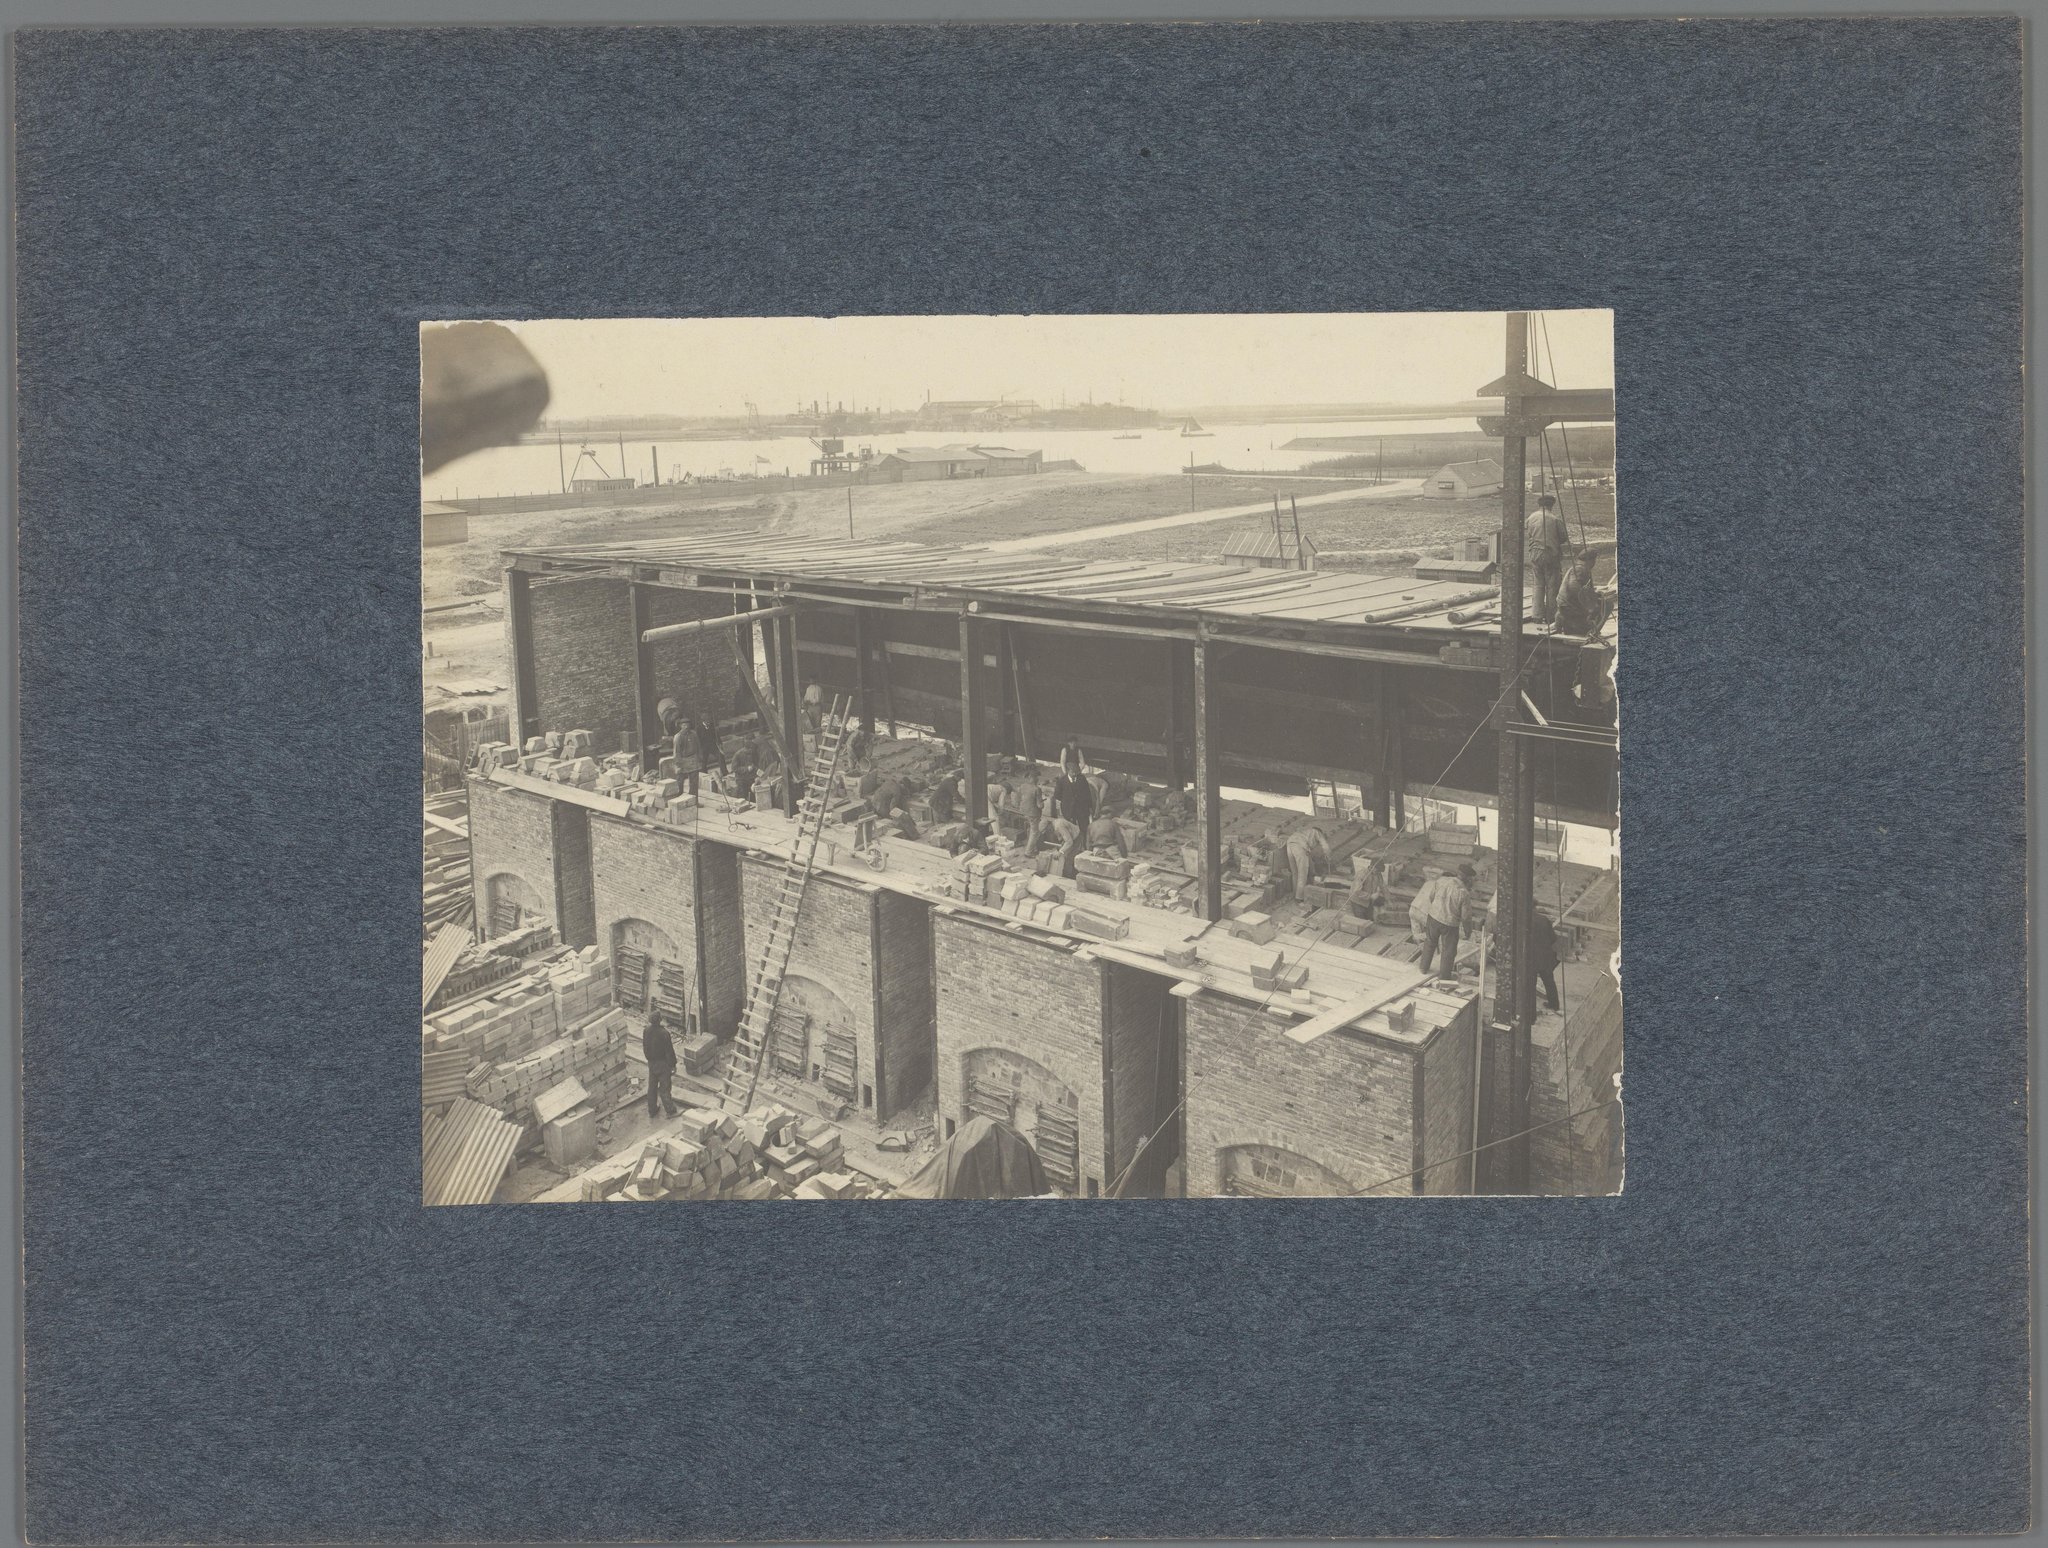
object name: photograph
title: Bouw van een opslagplaats in de Keilehaven, op de achtergrond de Maas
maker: willem sr. bleuzé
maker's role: fotograaf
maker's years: 1873-1948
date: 1912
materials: paper, cardboard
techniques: gelatin silver print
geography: rotterdam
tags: warehouse (~ harbour), building-site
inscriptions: address: ‘W. BLEUZÉ/ ROTTERDAM/ JONKER FRANSSTRAAT 66’